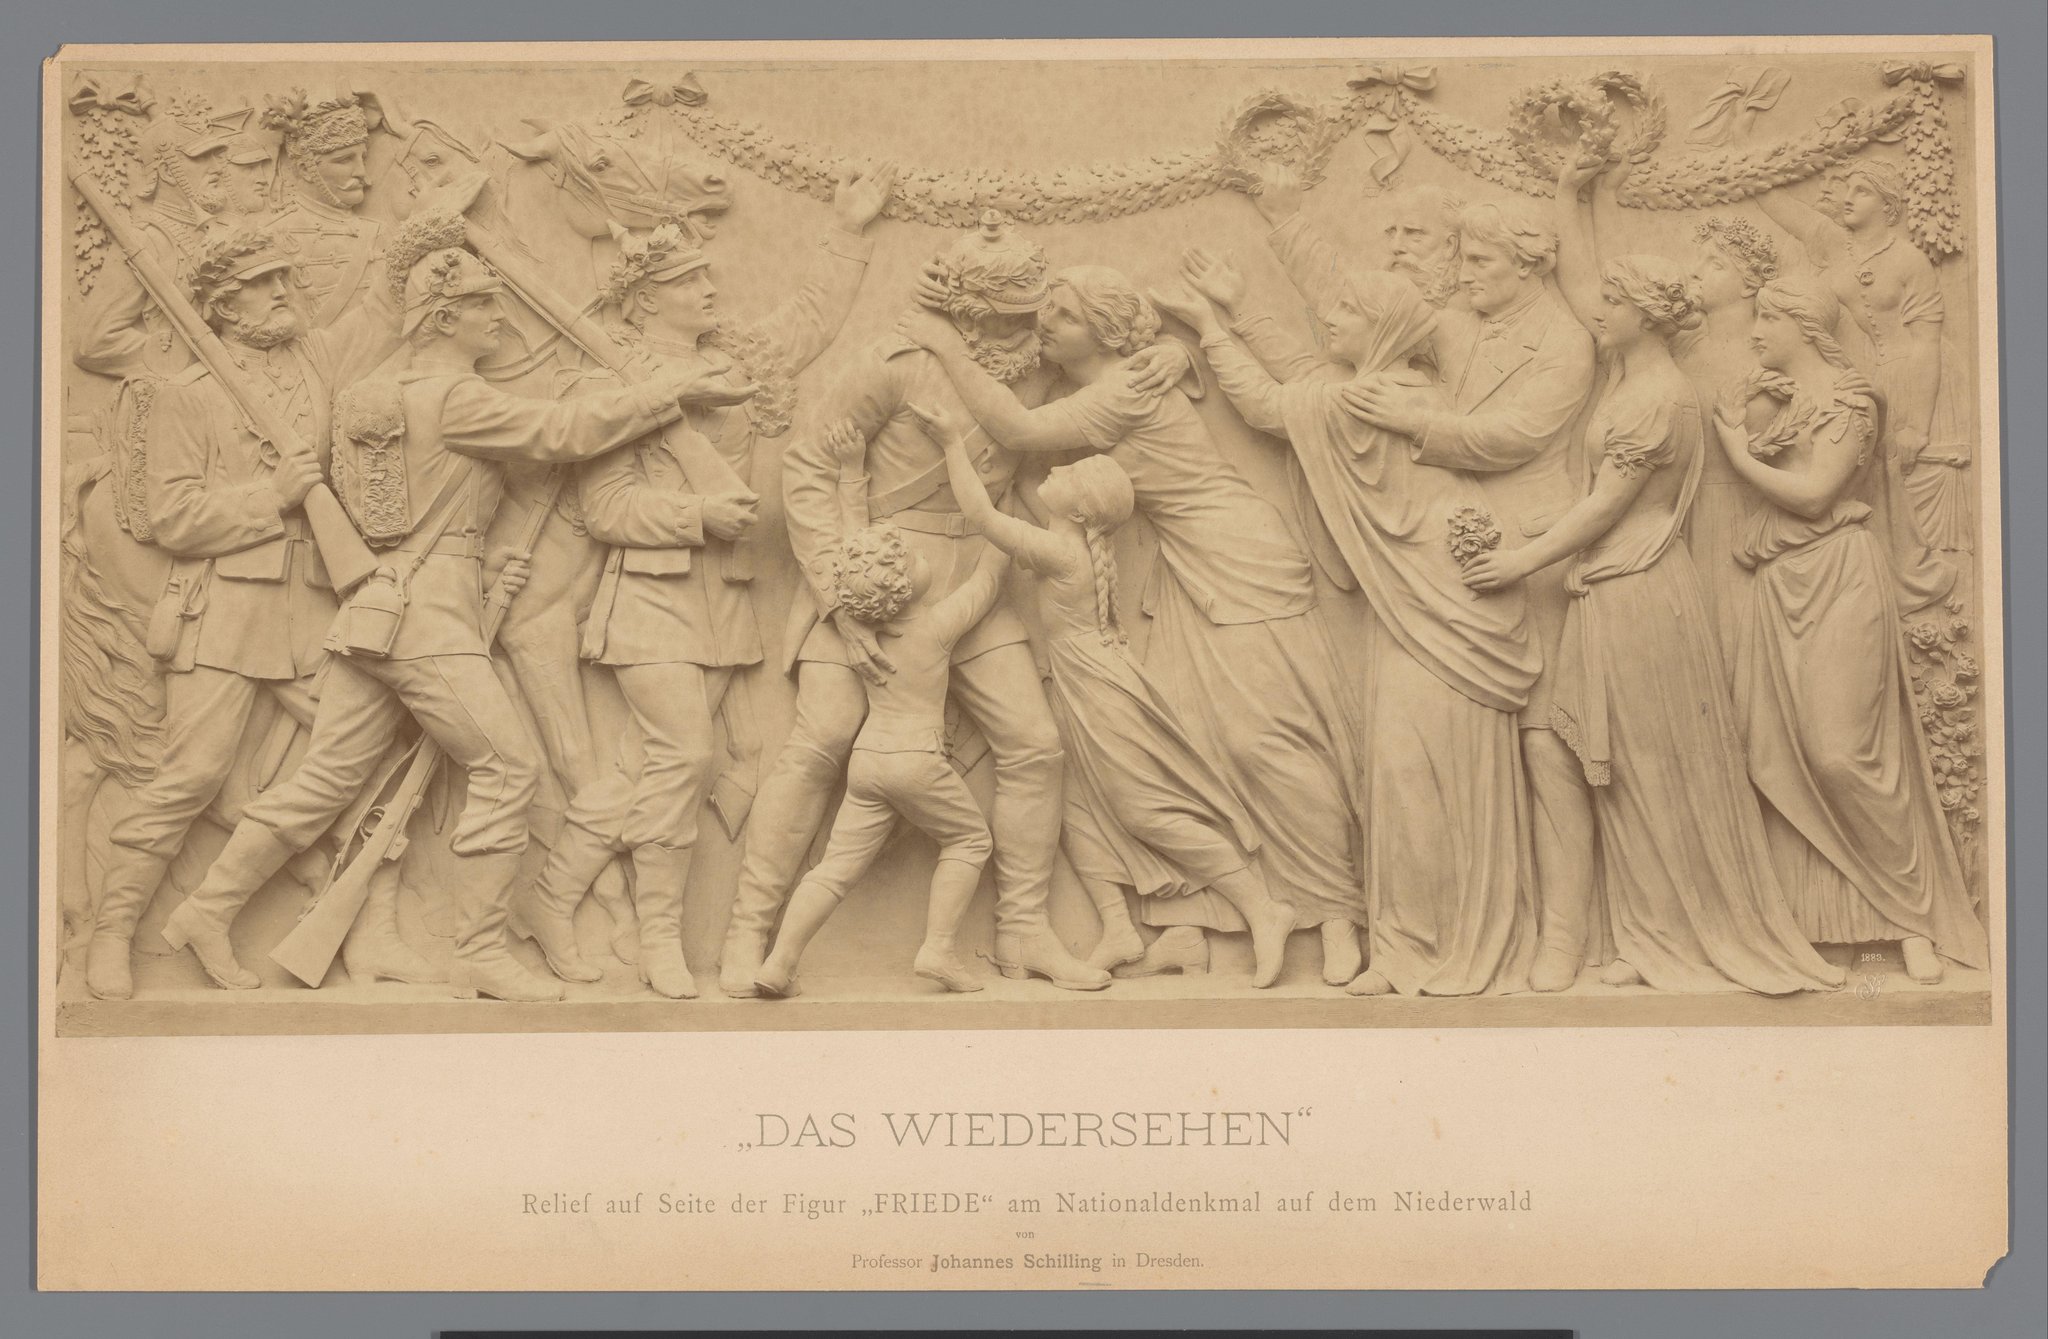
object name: photograph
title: Das Wiedersehen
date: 1887-1920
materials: paper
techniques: albumen print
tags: niederwald, frans-duitse oorlog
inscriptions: title: ‘"Das Wiedersehen" Relief auf Seite der Figur "Krieg"am Nationaldenkmal auf dem Niederwald von Professor Johannes Schilling in Dresden’, number: ‘'16.5’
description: Het National monument op de Niederwald is ogericht na de Frans Duitse oorlog